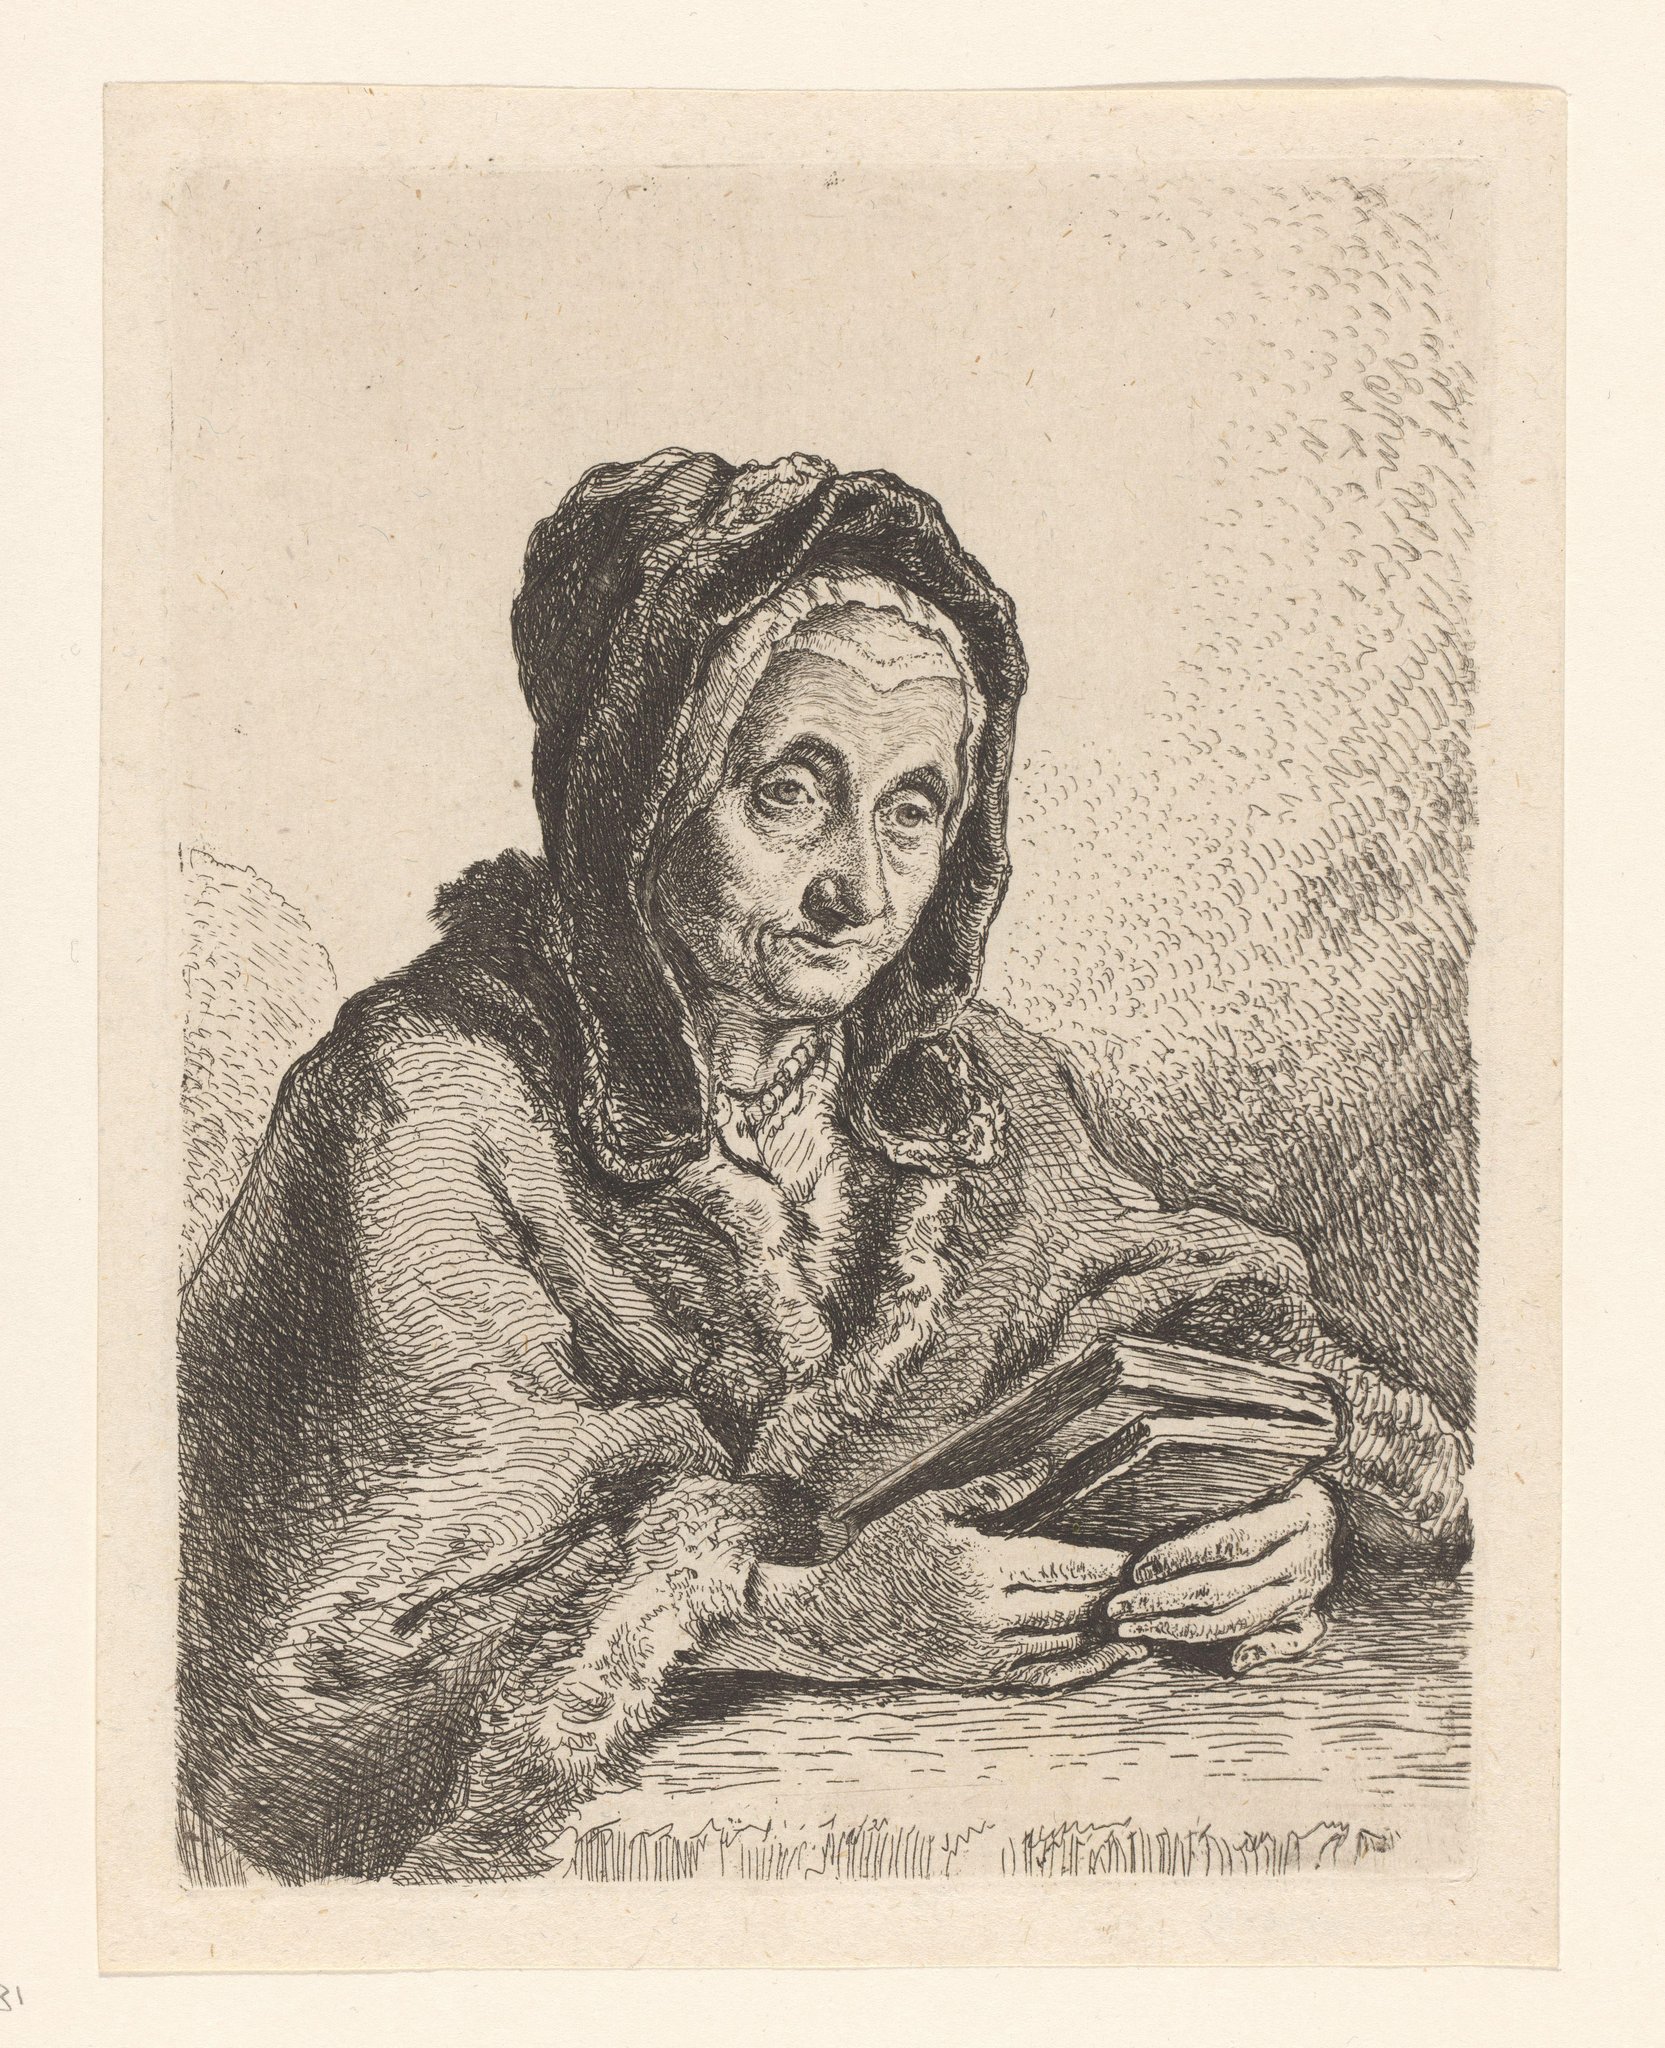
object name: print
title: Oude vrouw met boek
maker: joachim martin falbe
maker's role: print maker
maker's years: 1709-1782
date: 1750-1752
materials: paper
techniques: etching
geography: europe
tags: old woman, book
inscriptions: collector's mark: Lugt 2760, collector's mark: Lugt 2228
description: Twee afdrukken van dezelfde ets in twee verschillende staten (RP-P-2020-81 en RP-P-2020-82).